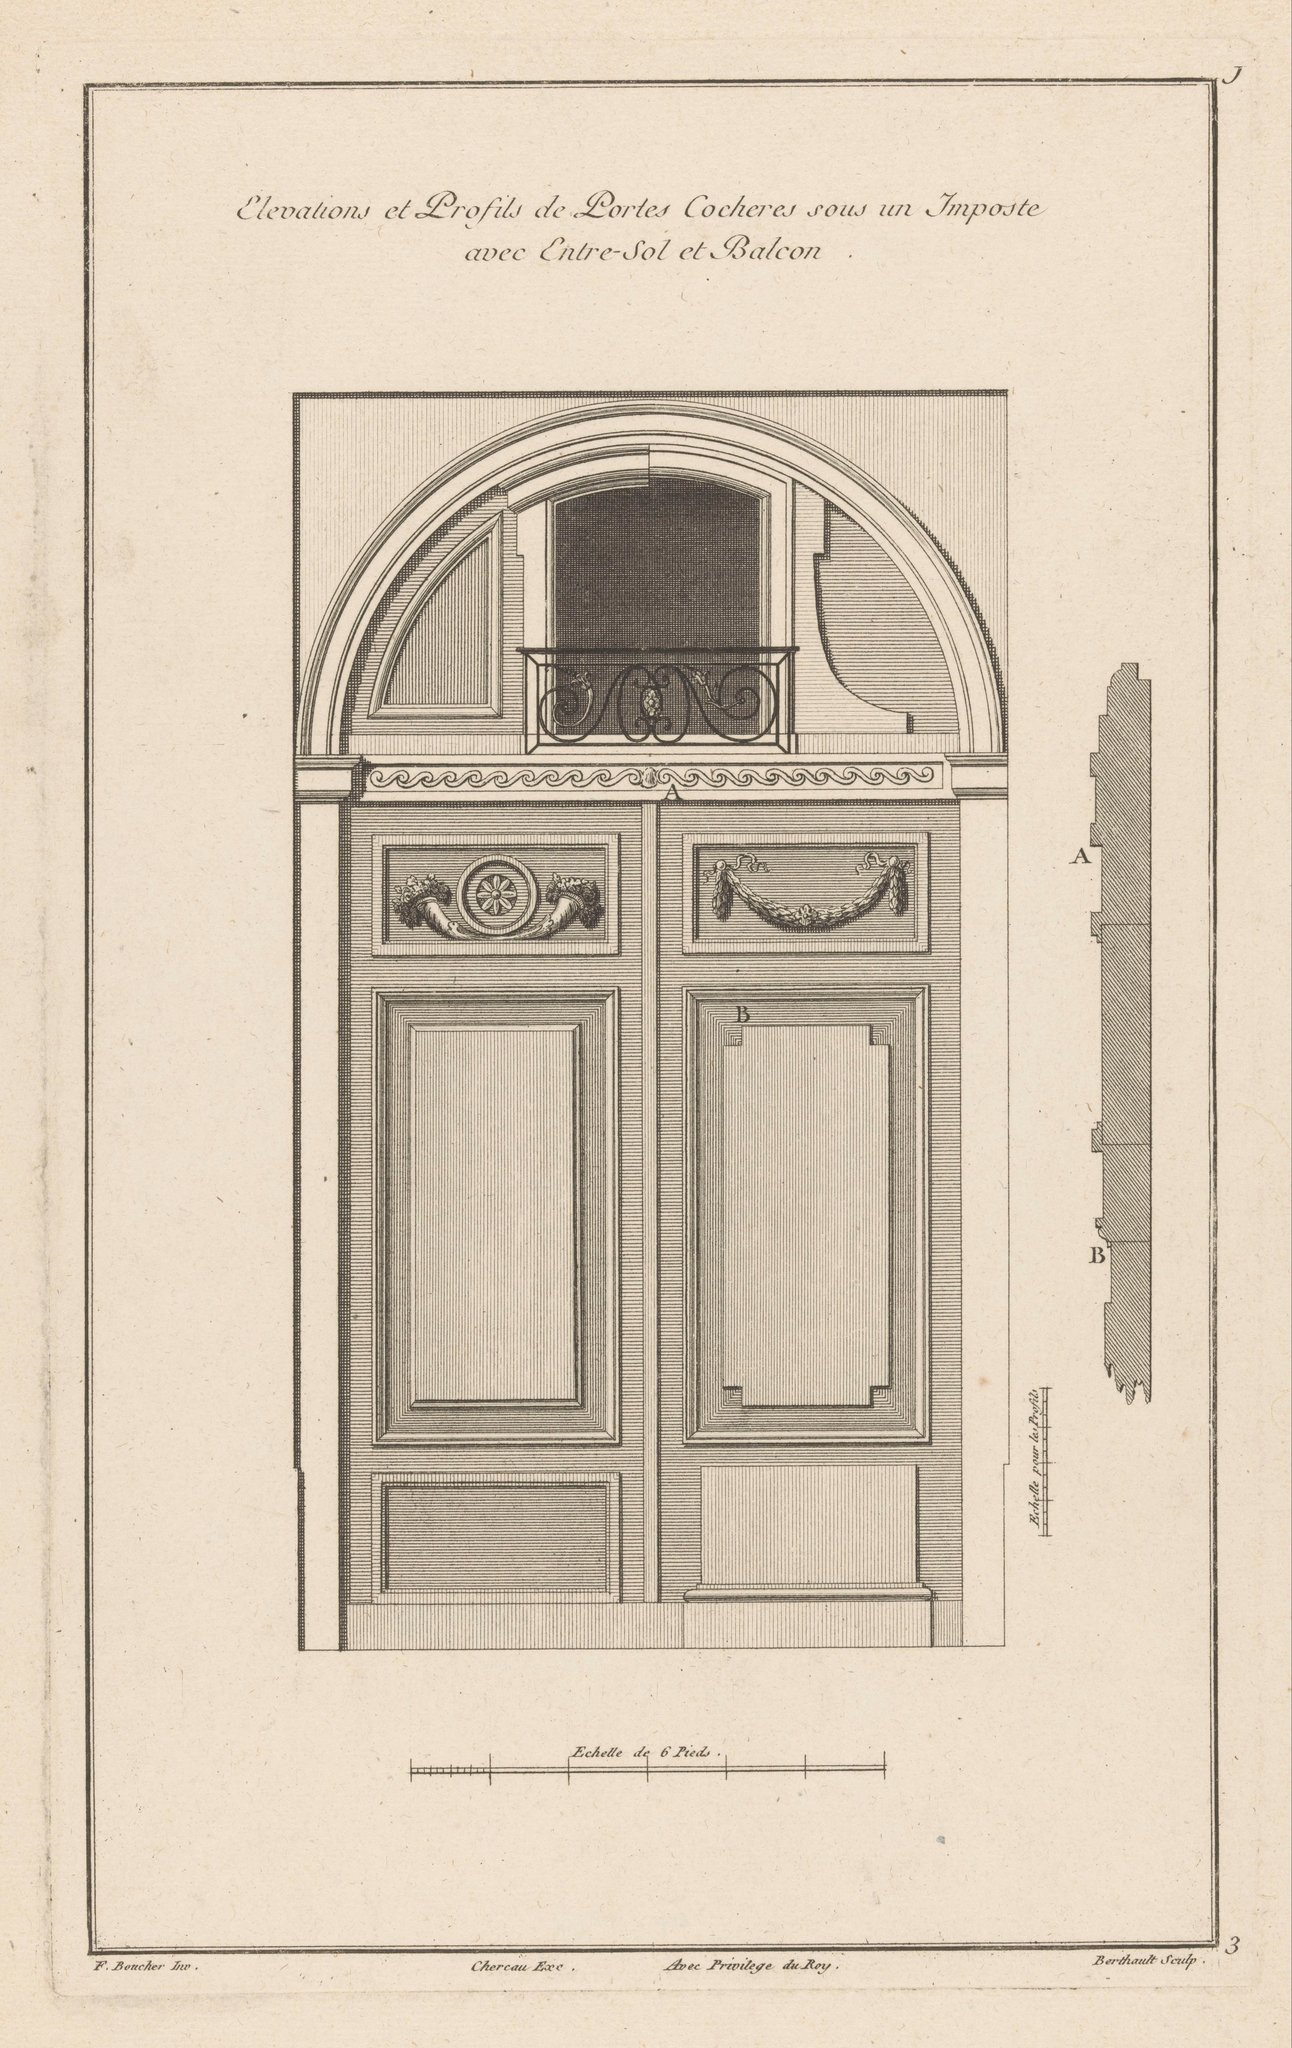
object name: ornament print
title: Elevations et Profils de Portes Cocheres sous un Imposte avec Entre-Sol et Balcon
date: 1752-1794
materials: paper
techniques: engraving, etching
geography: paris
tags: 'cornucopia', horn of plenty, monumental door, porch, 'aediculum', balcony, ornament ~ festoon, garland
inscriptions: collector's mark: Lugt 2228, collector's mark: Lugt 2760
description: Ontwerp en profiel van een koetspoort met daarboven een balkon. De deuren van de poort zijn gedecoreerd met hoornen des overvloeds en een guirlande.